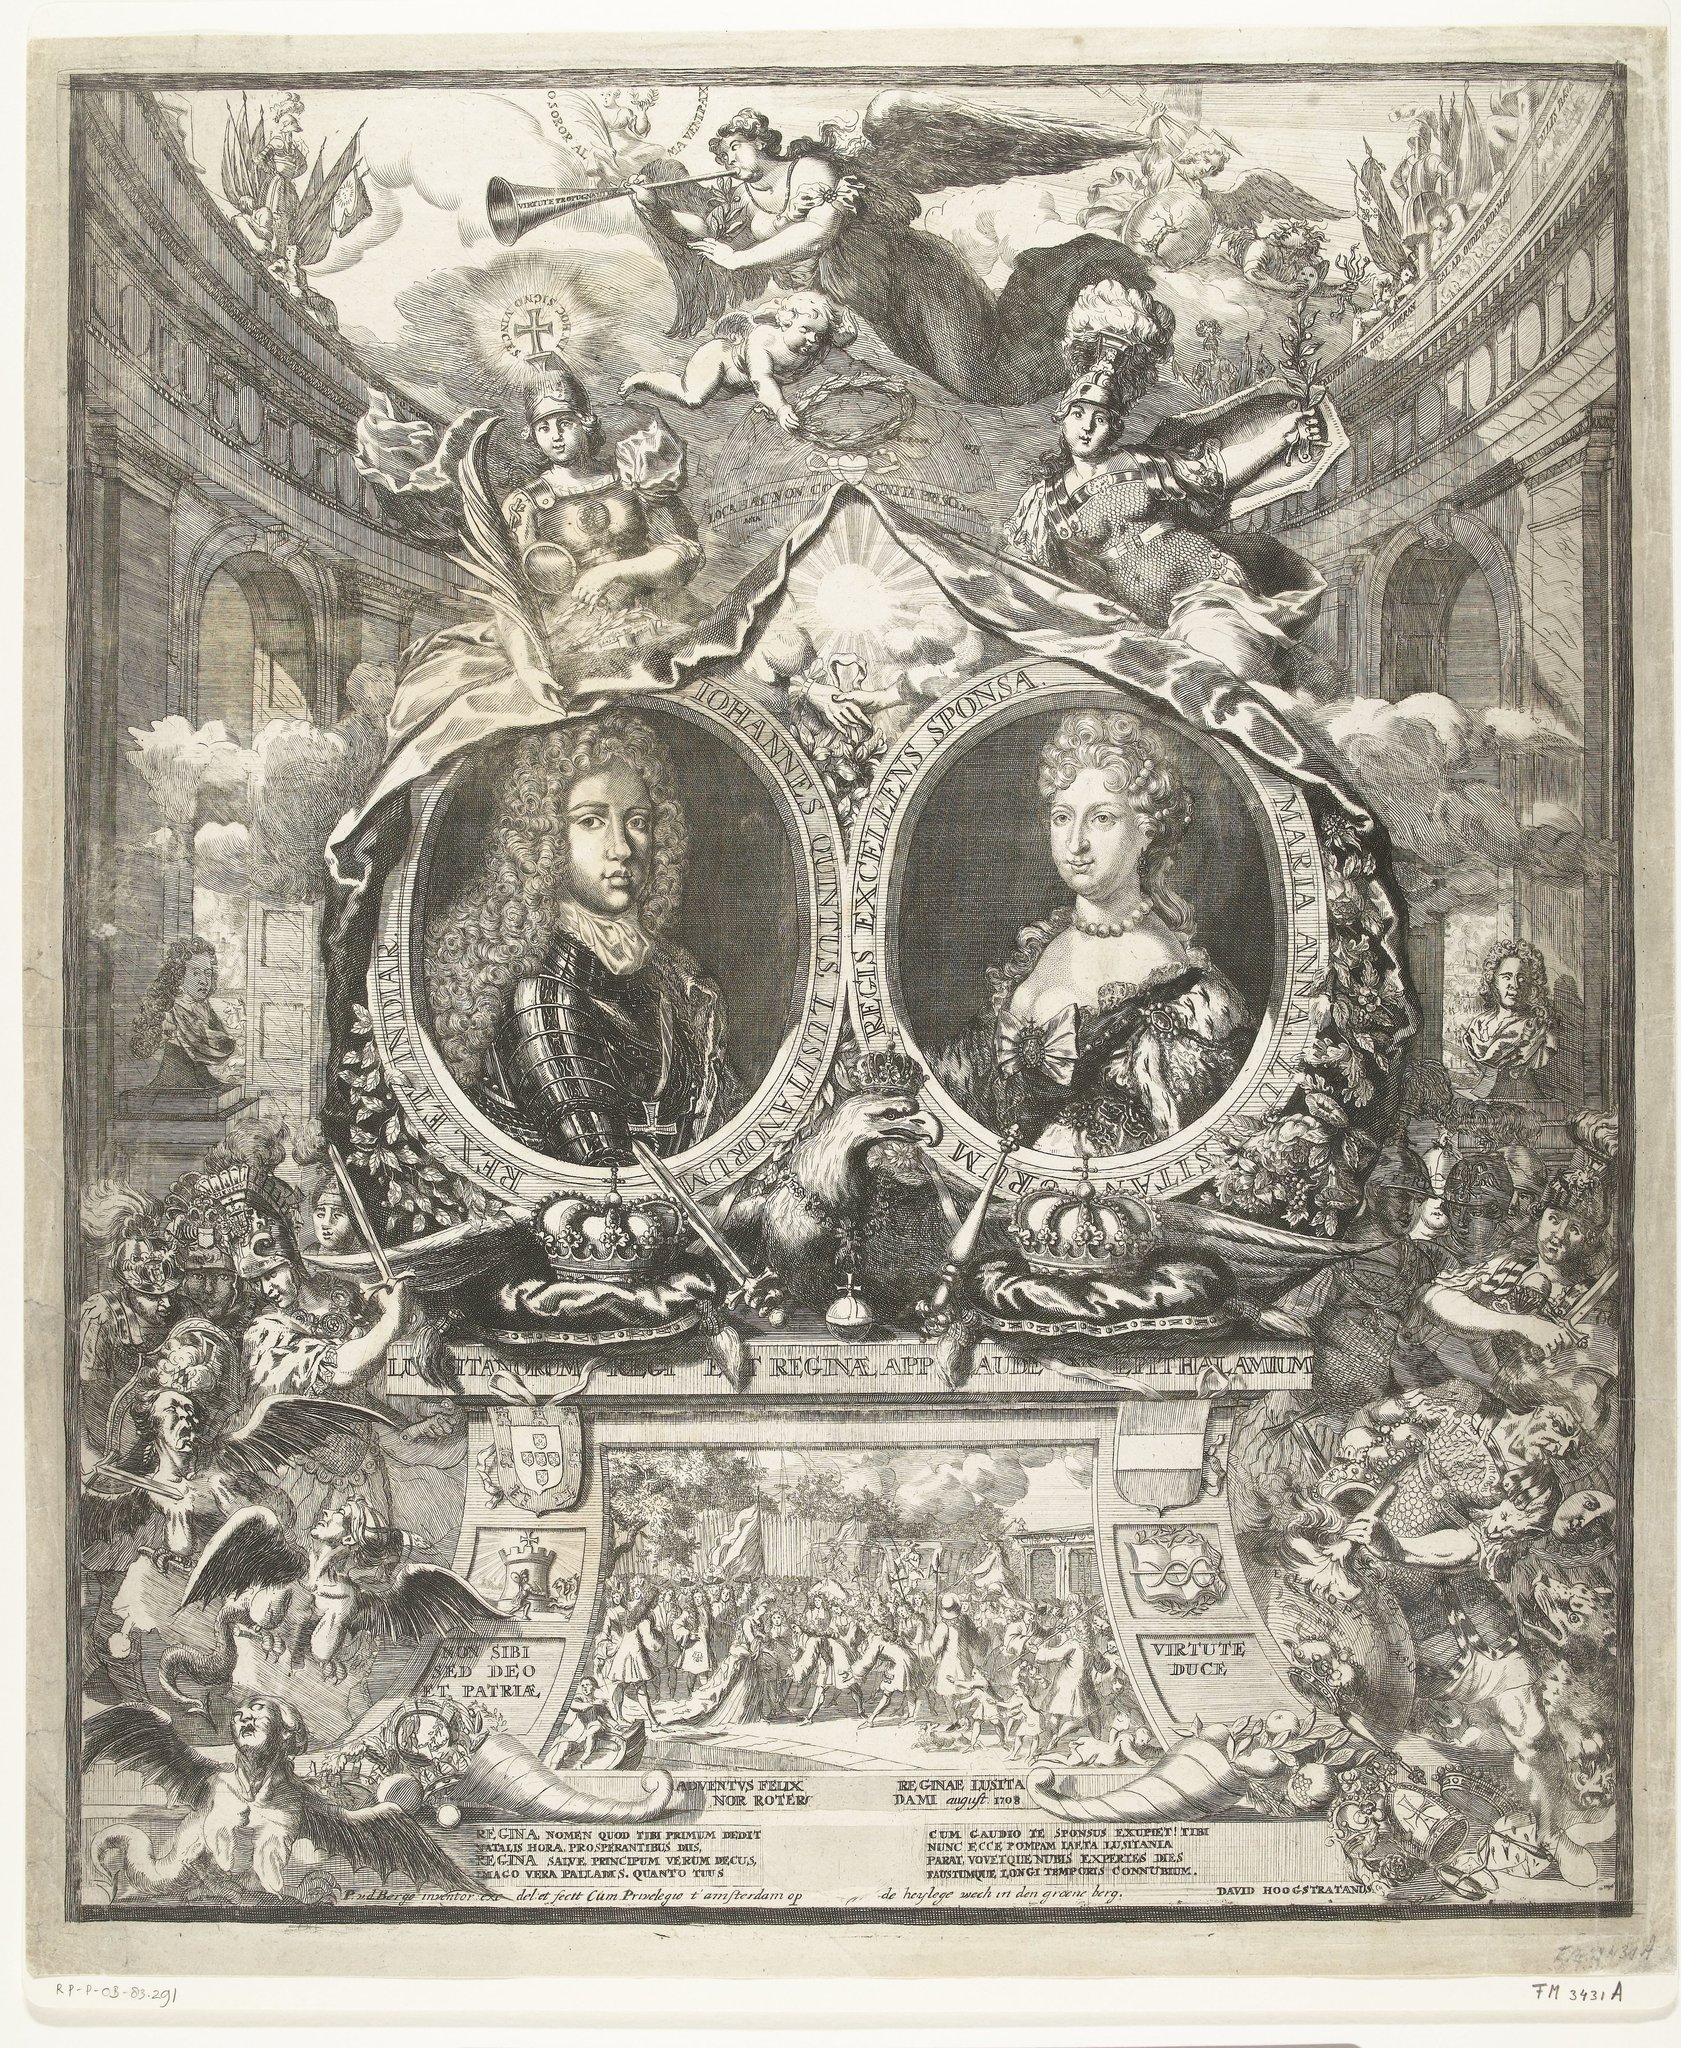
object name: print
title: Huwelijksprent voor koning Johan V van Portugal, 1708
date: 1708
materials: paper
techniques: engraving, etching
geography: amsterdam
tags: (civil) marriage ceremonies, rotterdam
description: Prent ter gelegenheid van het huwelijk tussen koning Johan V van Portugal en Maria Anna van Oostenrijk op 27 oktober 1708. Portretten in medaillons omgeven door symbolen van trouw en verbond, allegorische figuren en de Oostenrijkse adelaar. Onderaan een voorstelling van het bezoek de aartshertogin Maria Anna van Oostenrijk aan Rotterdam in augustus 1708. Opschriften en onderschrift in het Latijn.